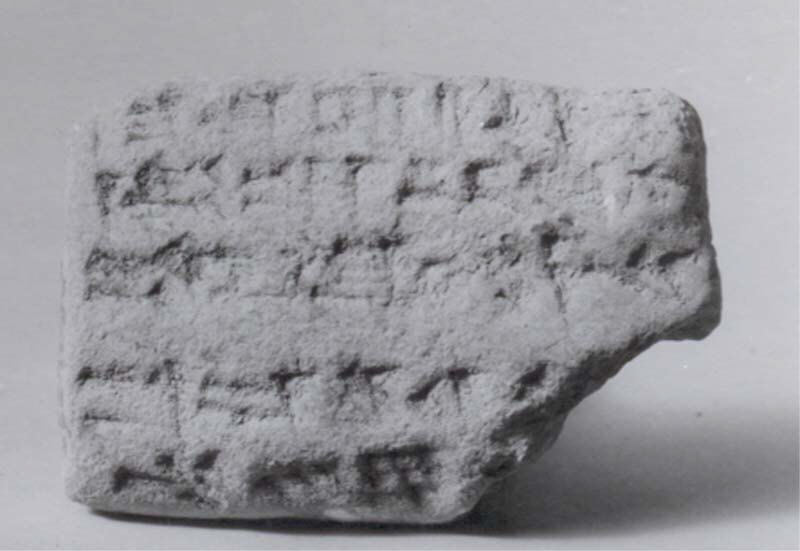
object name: cuneiform tablet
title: Cuneiform tablet: account of barley issue for a prebendary, Ebabbar archive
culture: babylonian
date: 586 BCE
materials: clay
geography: mesopotamia